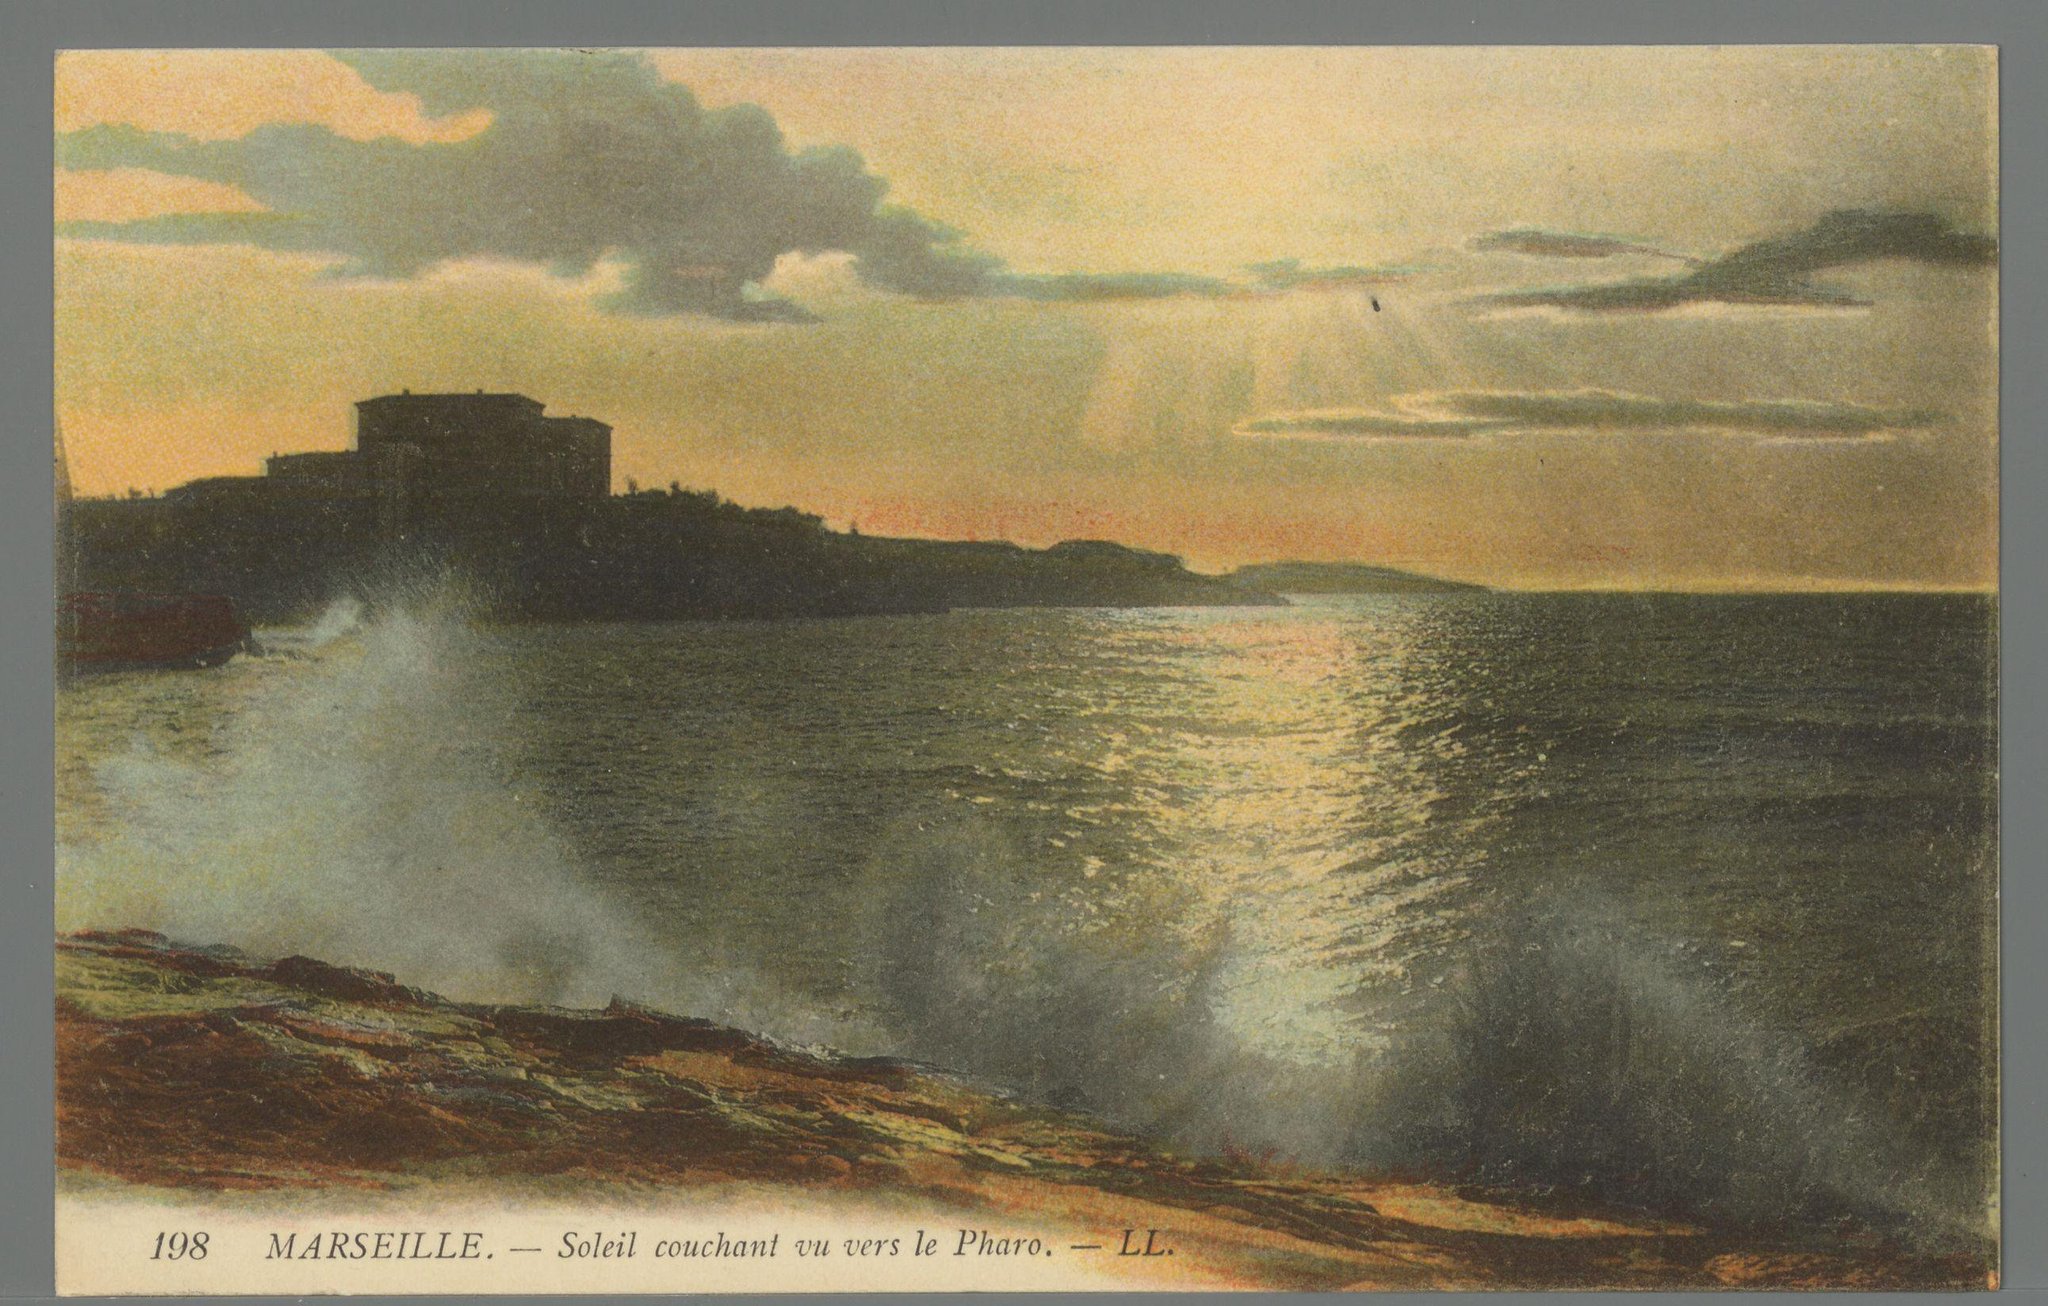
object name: photomechanical print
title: Marseille. Soleil couchant vu vers le Pharo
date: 1903-1920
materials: cardboard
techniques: photograph, lithograph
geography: paris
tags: sea (seascape), sunset, marseille